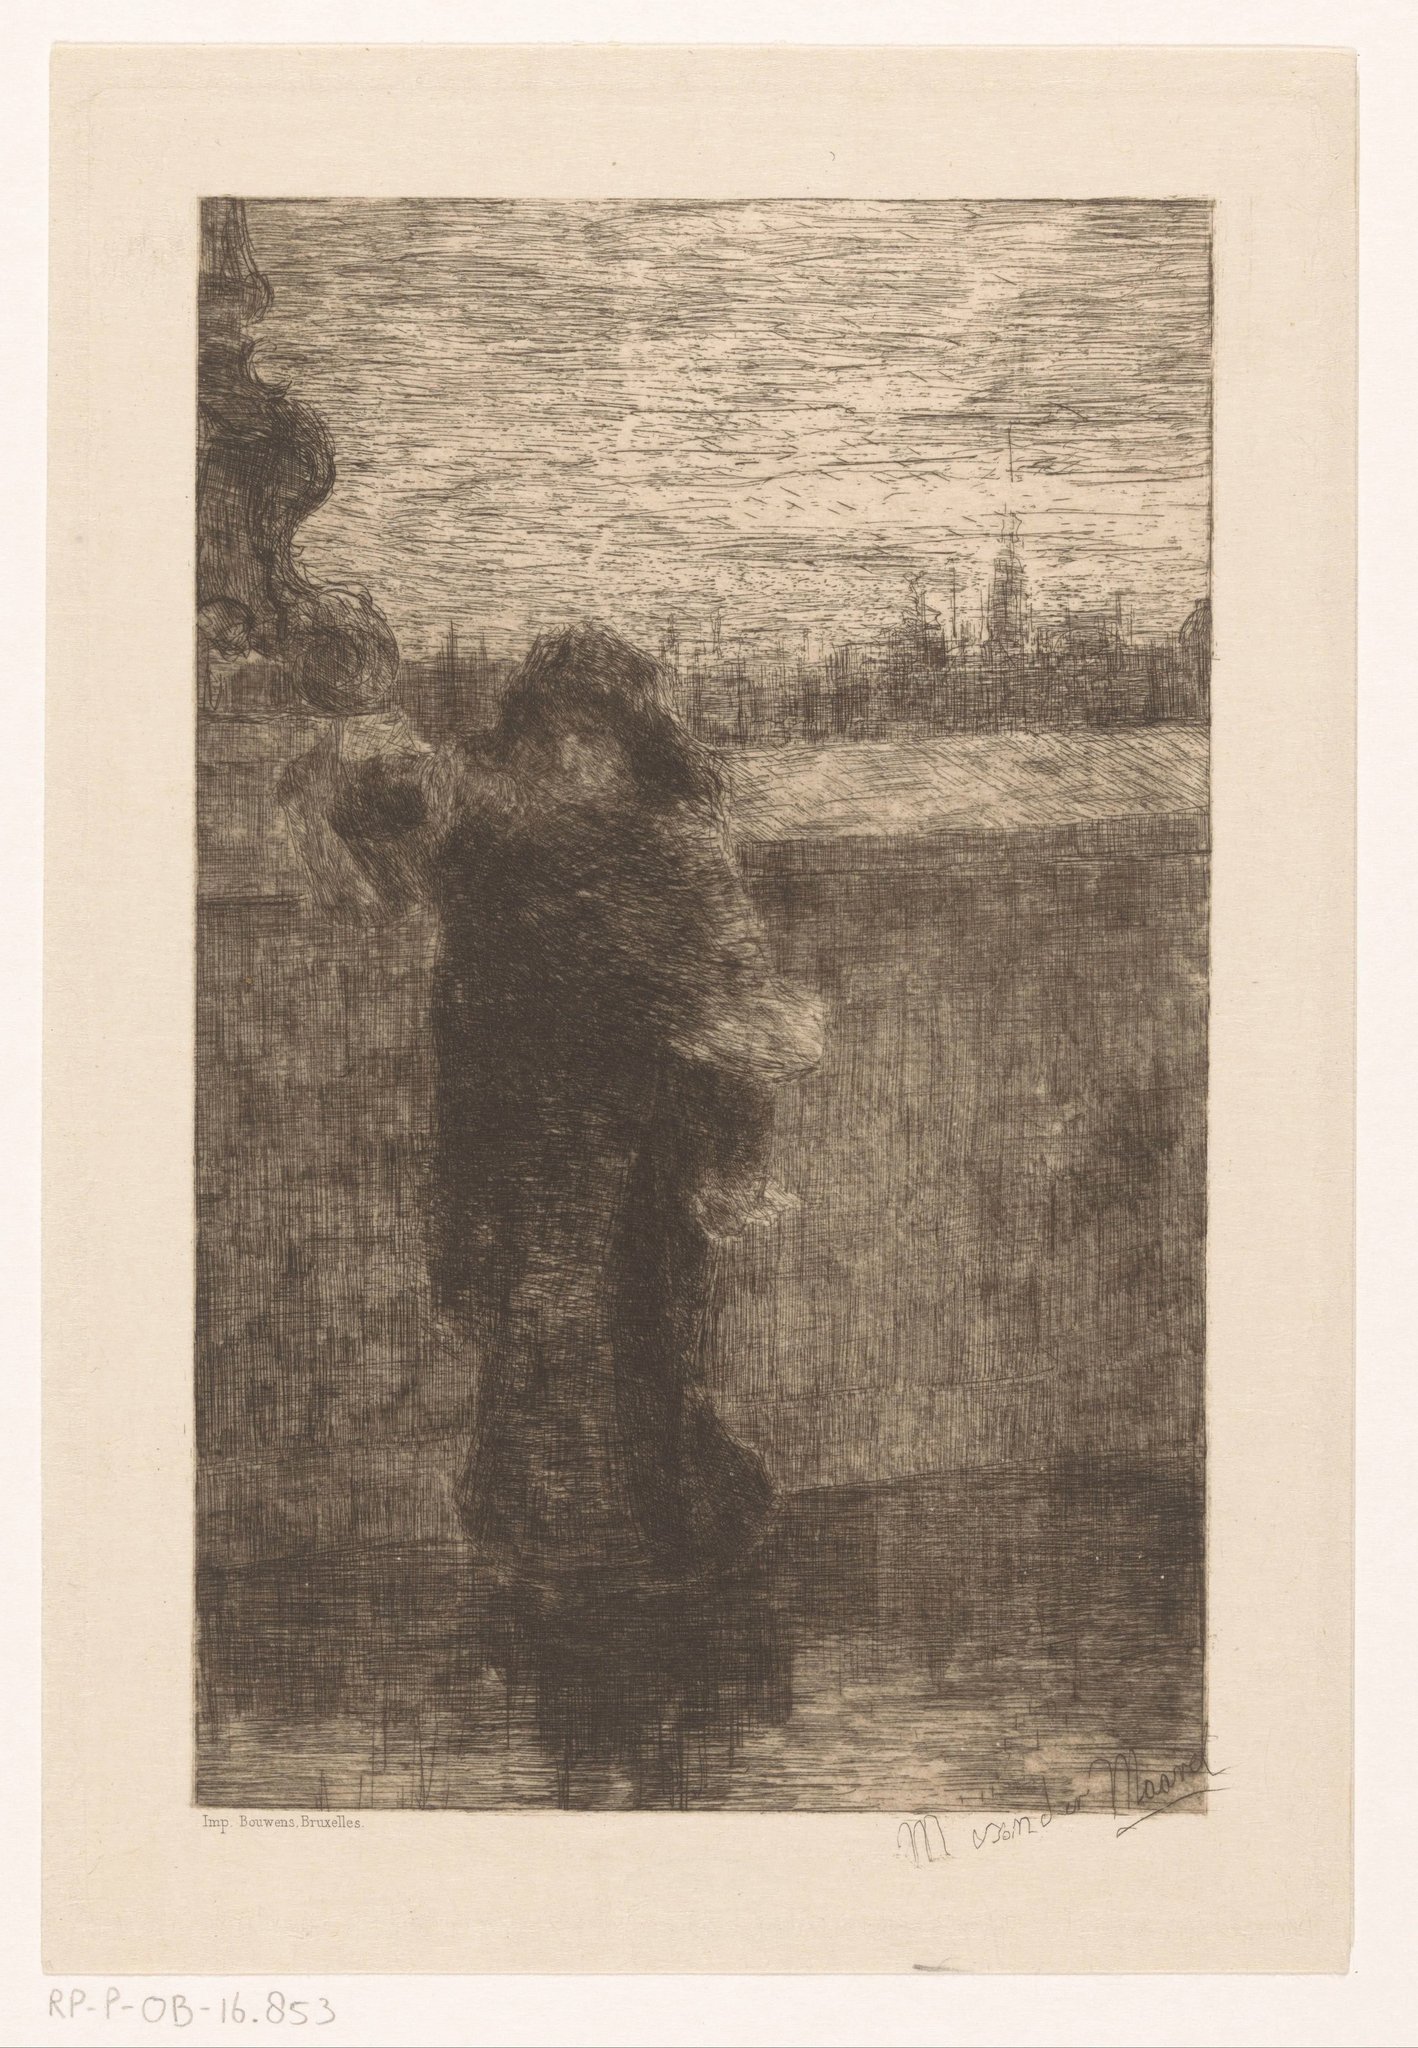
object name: print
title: Vrouw met mantel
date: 1867-1921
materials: paper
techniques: etching, intaglio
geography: brussels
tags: adult woman, coat, cape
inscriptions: collector's mark: Lugt 2228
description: Een vrouw met een hoed en een mantel staat voor een muur. Op de achtergrond het silhouet van een stad.